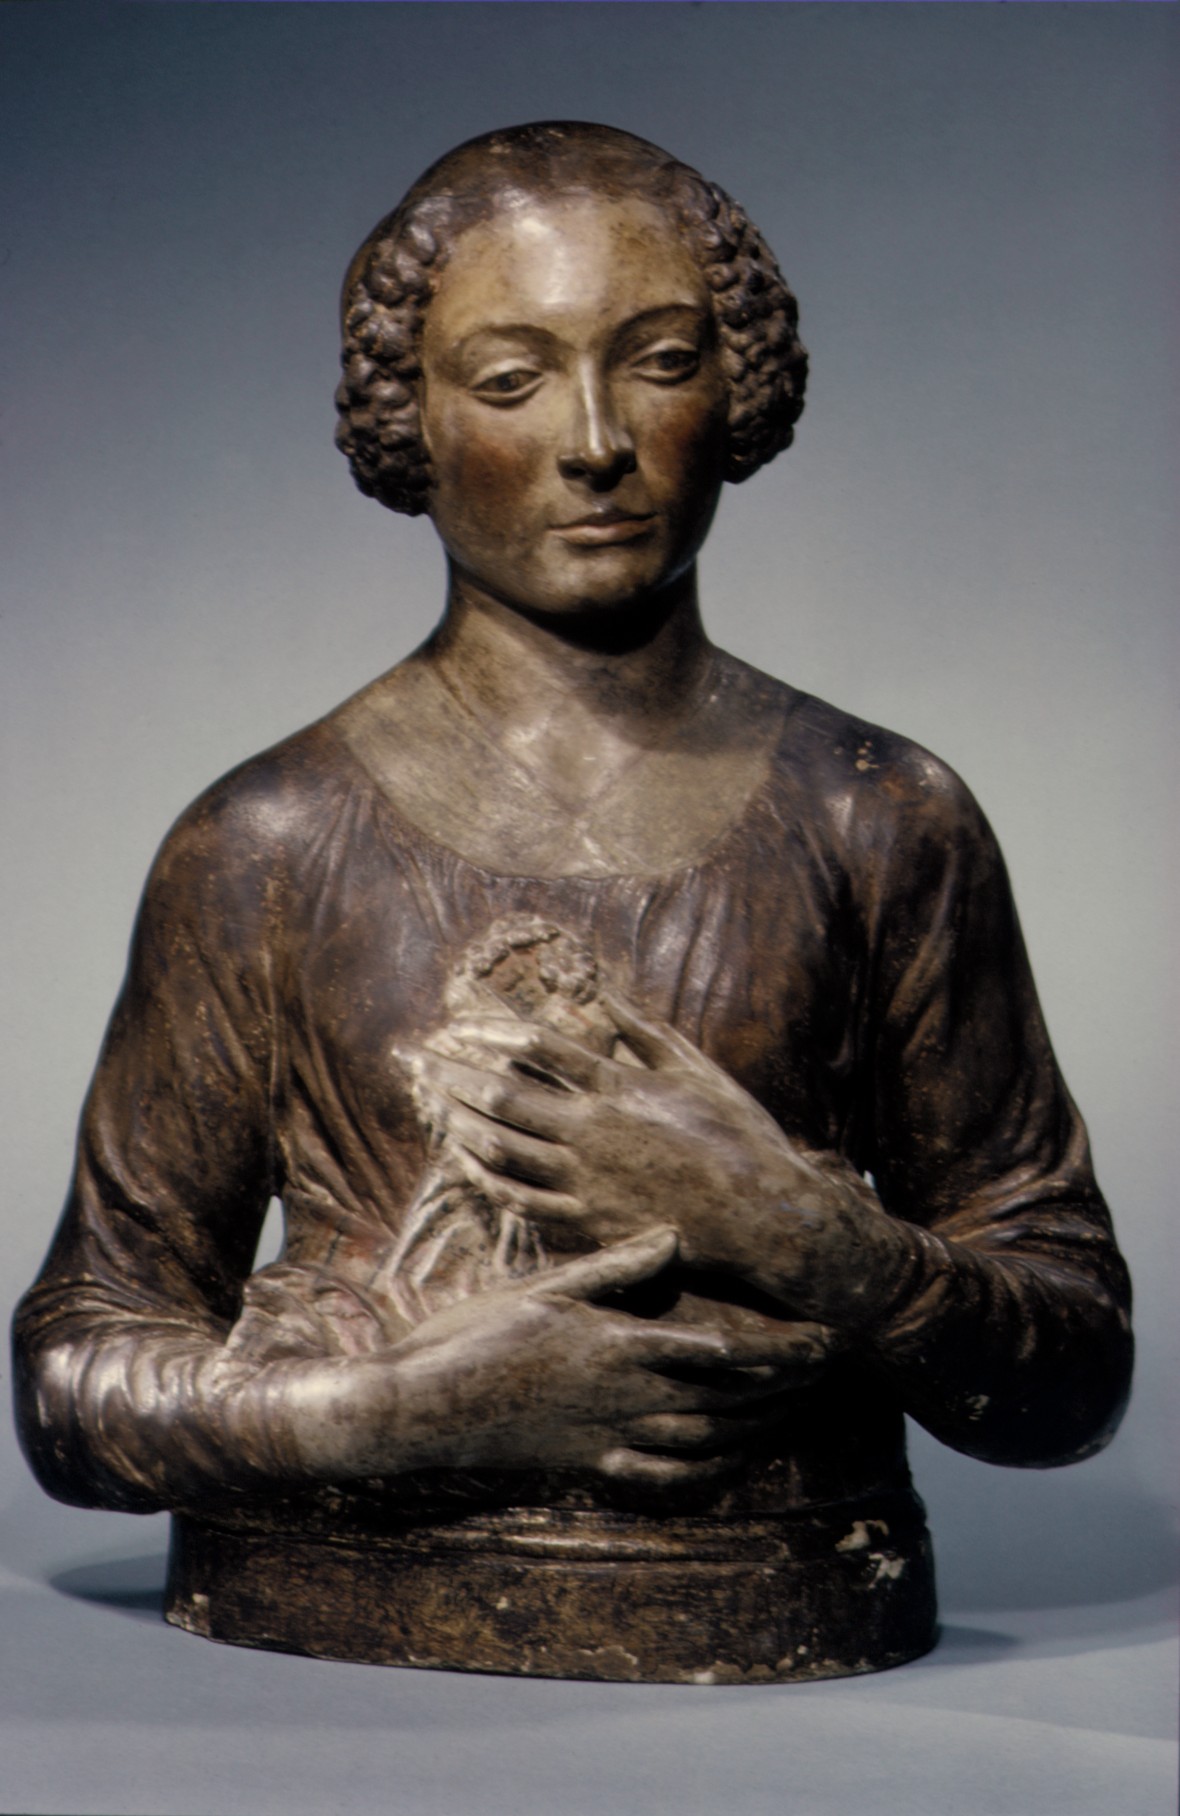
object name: half length statue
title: Lady holding a bunch of flowers to her breast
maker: andrea del verrocchio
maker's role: artist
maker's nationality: italian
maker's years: 1435-1488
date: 1867-1900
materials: gilt, plaster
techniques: polychrome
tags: portraits,women,flowers